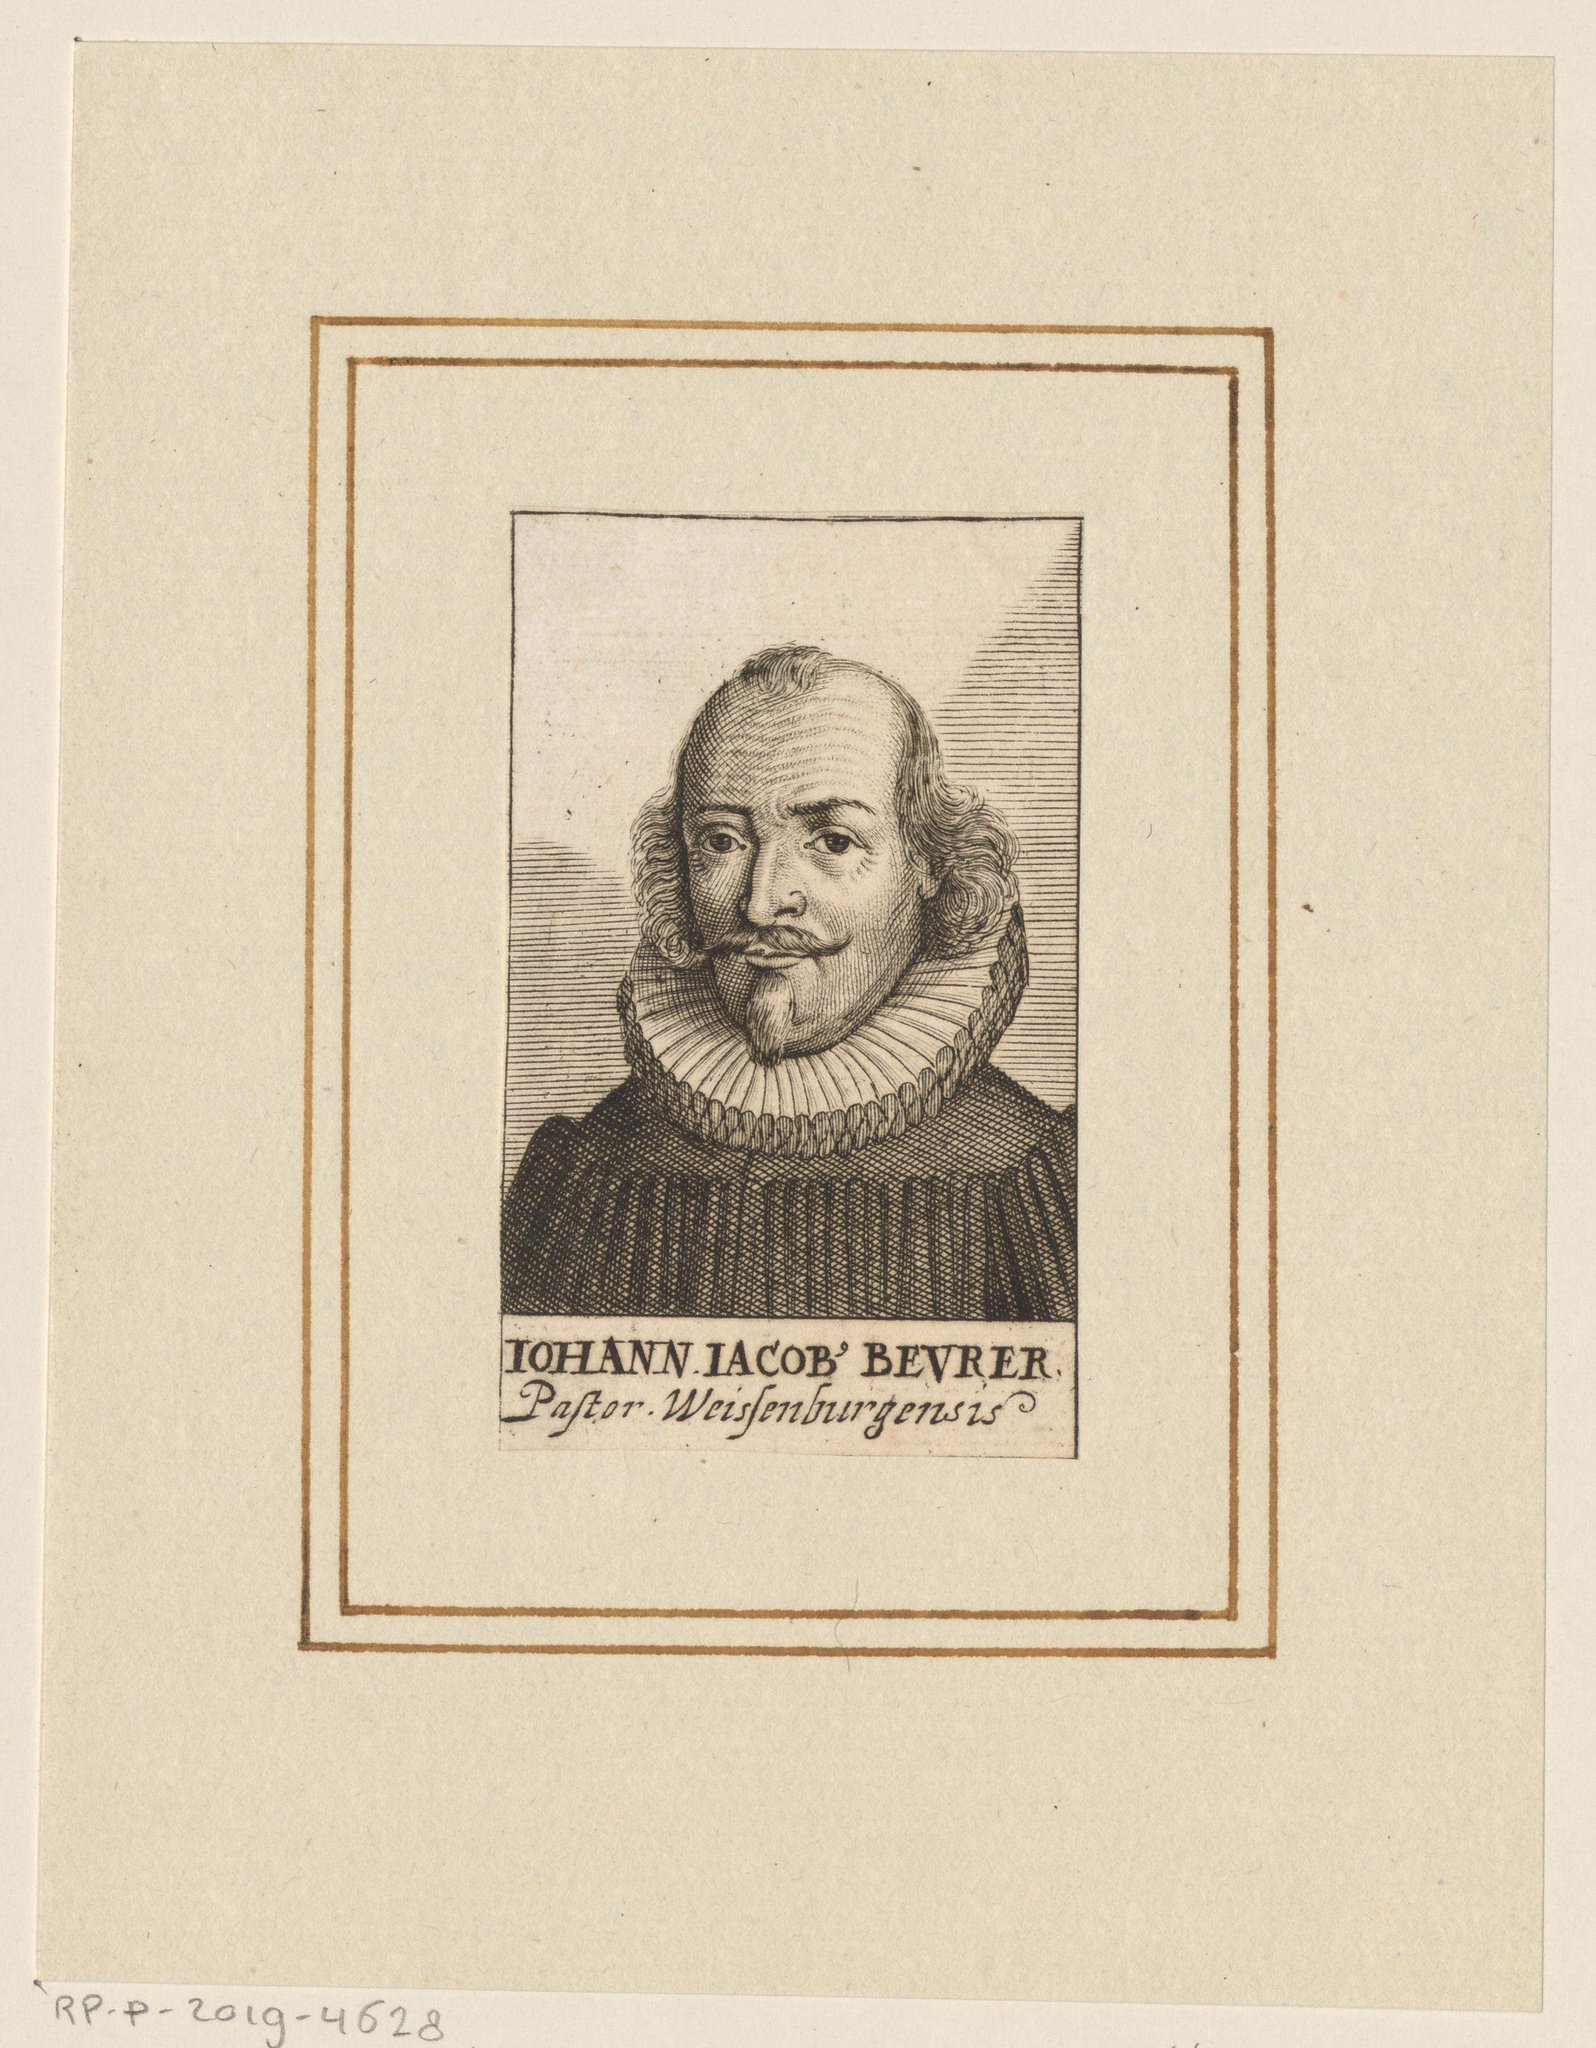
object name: print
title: Portret van Johann Jacob Beurer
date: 1688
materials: paper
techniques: engraving, etching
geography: nuremberg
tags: theologian, historical persons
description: Prent uit: Freher, Paul. Theatrum virorum eruditione clarorum. Neurenberg: Johann Hoffmann, 1688.